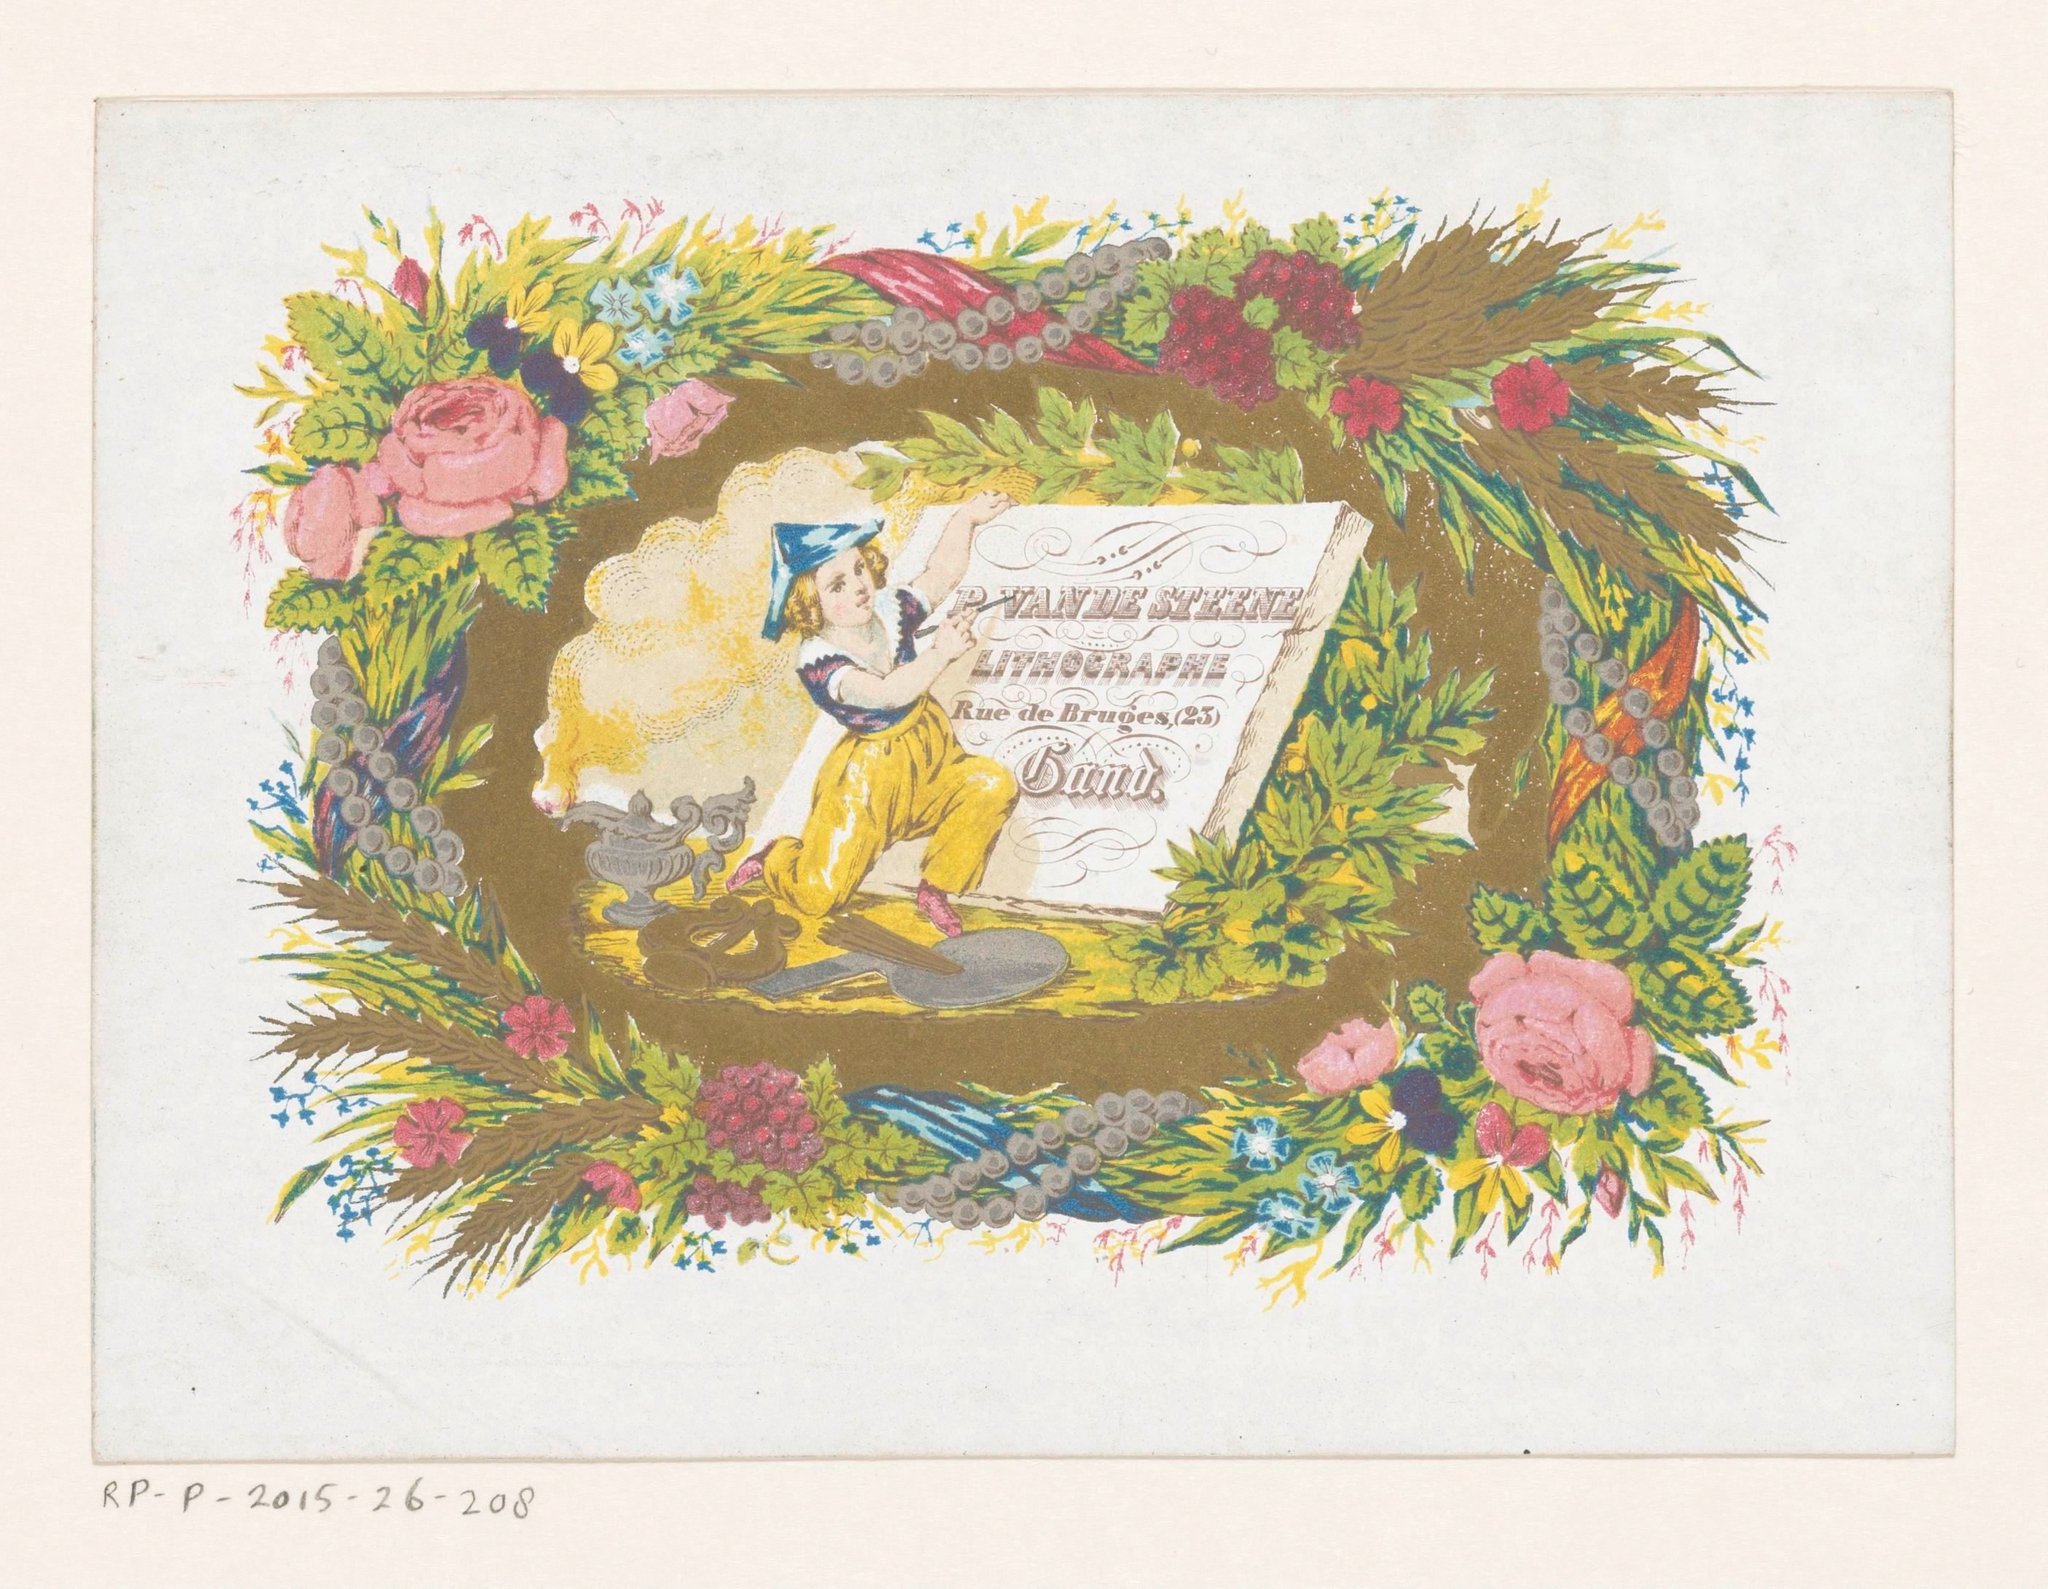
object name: print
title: Visitekaartje van drukkerij Pierre Vande Steene te Gent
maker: pierre vande steene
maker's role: print maker, printer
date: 1850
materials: porcelainized cardboard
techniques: lithograph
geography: ghent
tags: lithographer, lyre, cithara, psaltery, still life of related objects, oil-lamp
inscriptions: collector's mark: Lugt 2228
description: In een omlijsting van bloemen schrijft een jongen met een papieren hoedje op een lithosteen. Op de grond een olielamp, een lier, een winkelhaak en een schilderspalet.